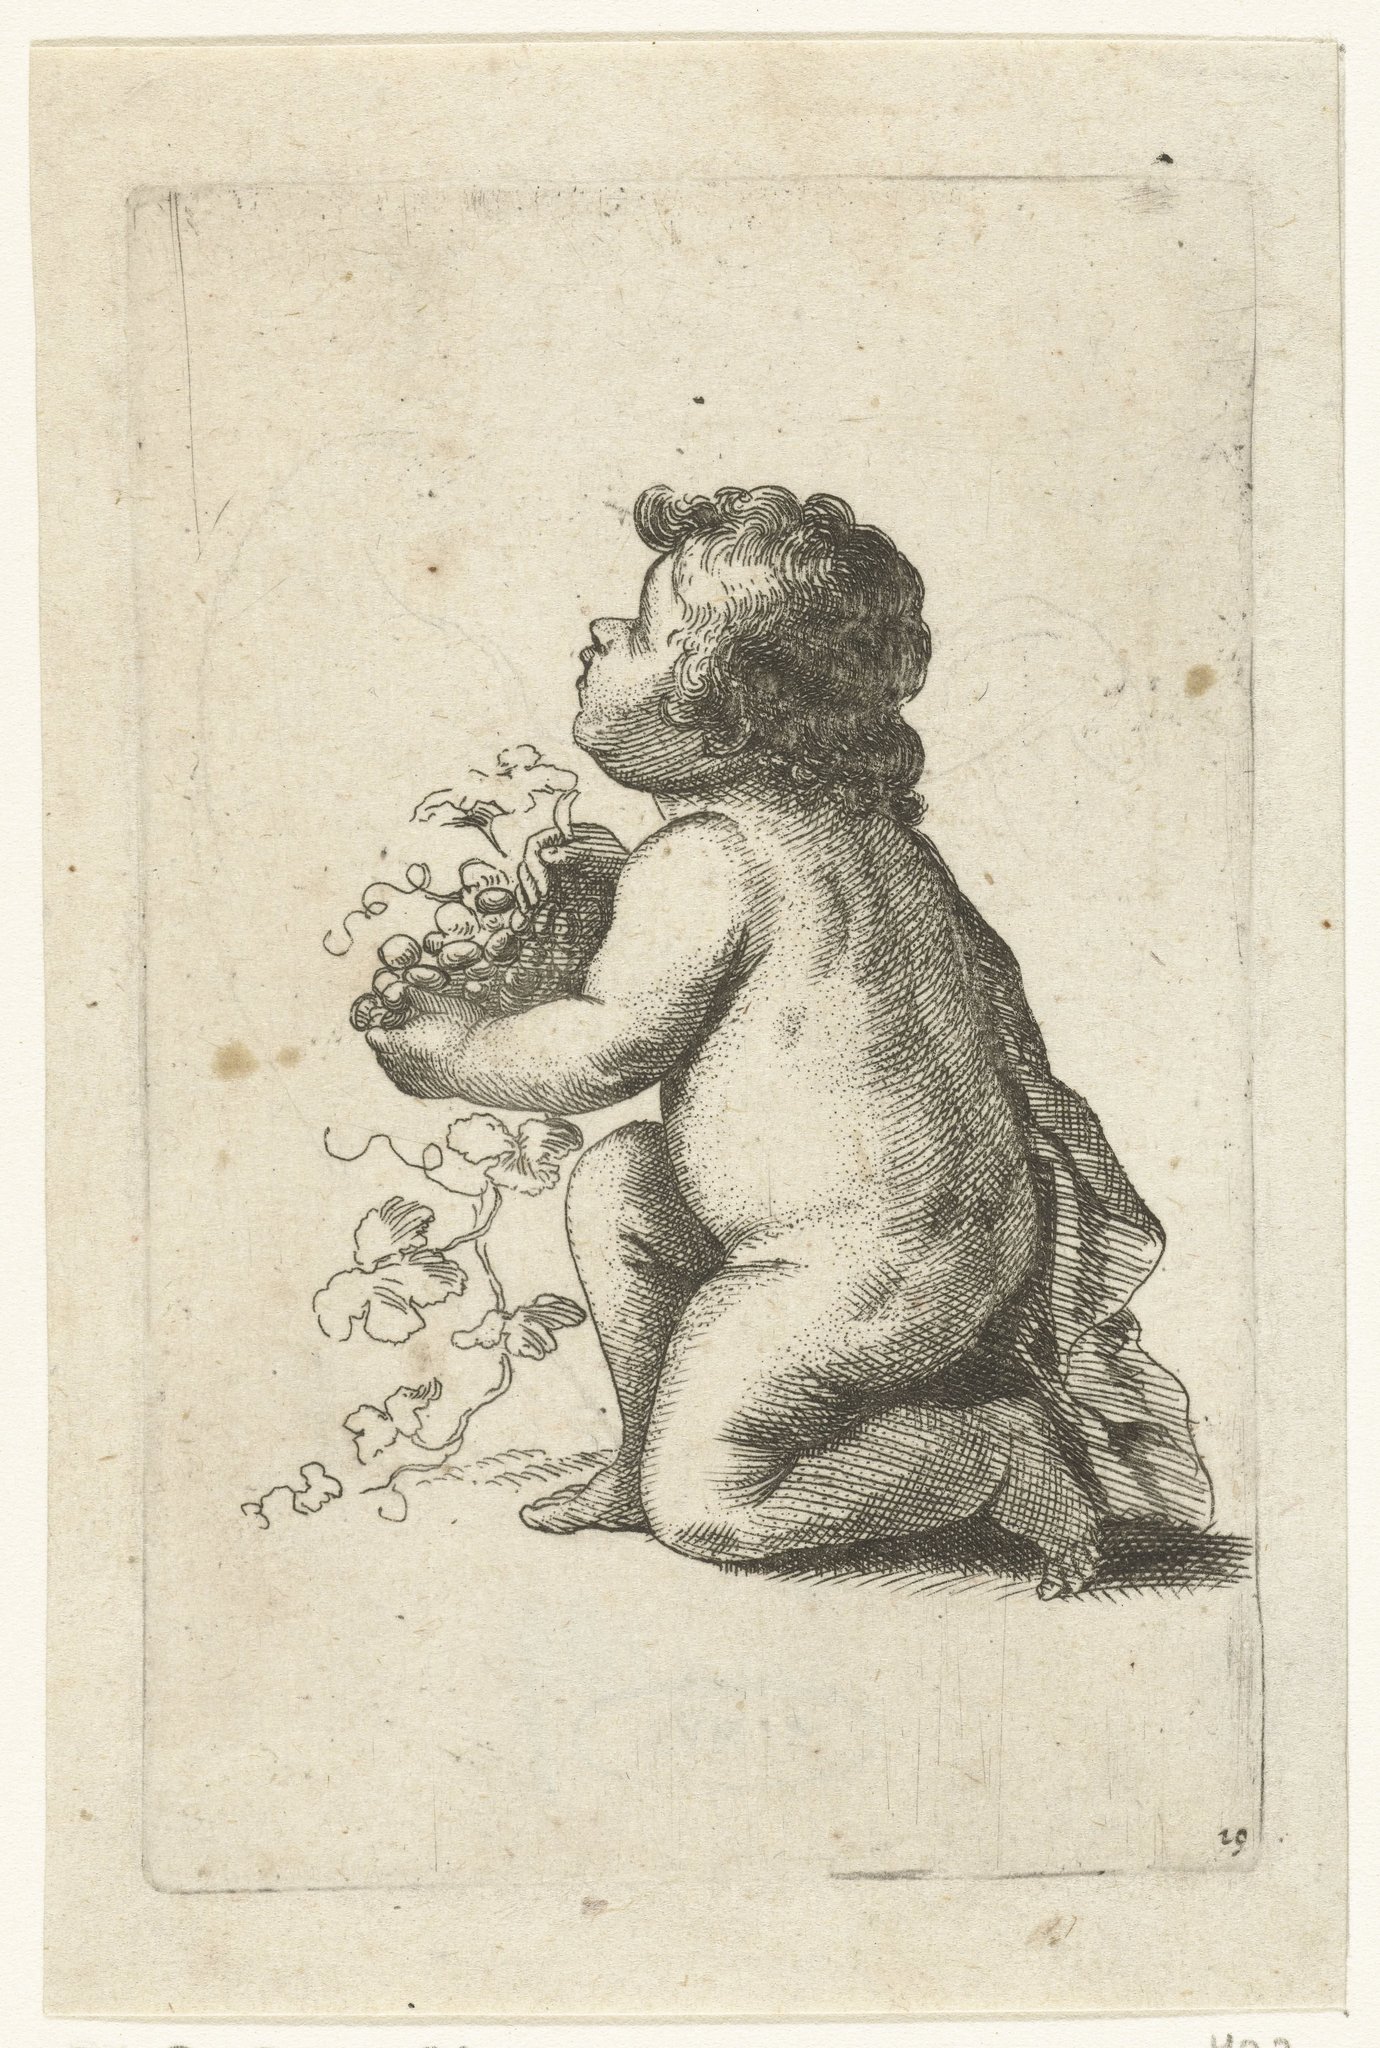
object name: print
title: Knielend kind met druiventros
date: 1630-1652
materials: paper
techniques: engraving, etching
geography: amsterdam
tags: child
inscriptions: collector's mark: Lugt 2228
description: Knielend kind met druiventros. Prent uit een serie van 24 prenten met engelen of kinderen.